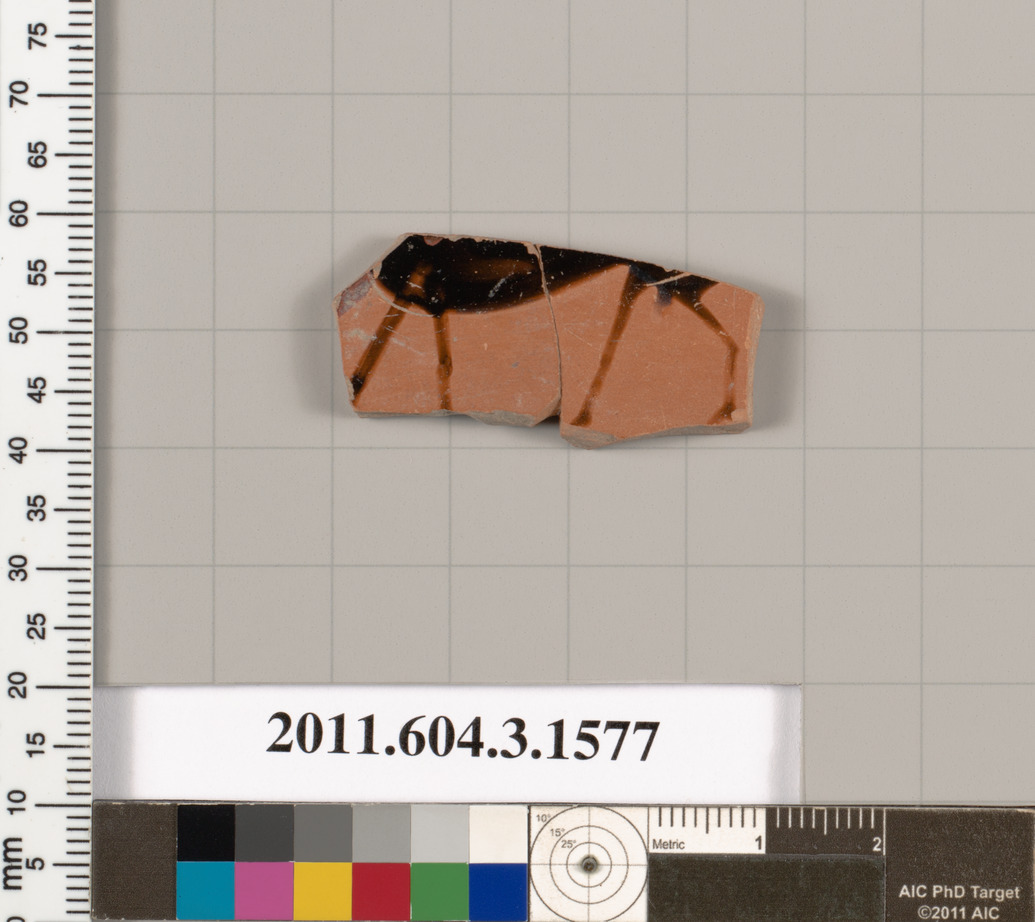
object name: kylix fragment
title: Terracotta fragment of a kylix: Band cup (drinking cup)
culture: greek, attic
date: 550-526 BCE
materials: terracotta